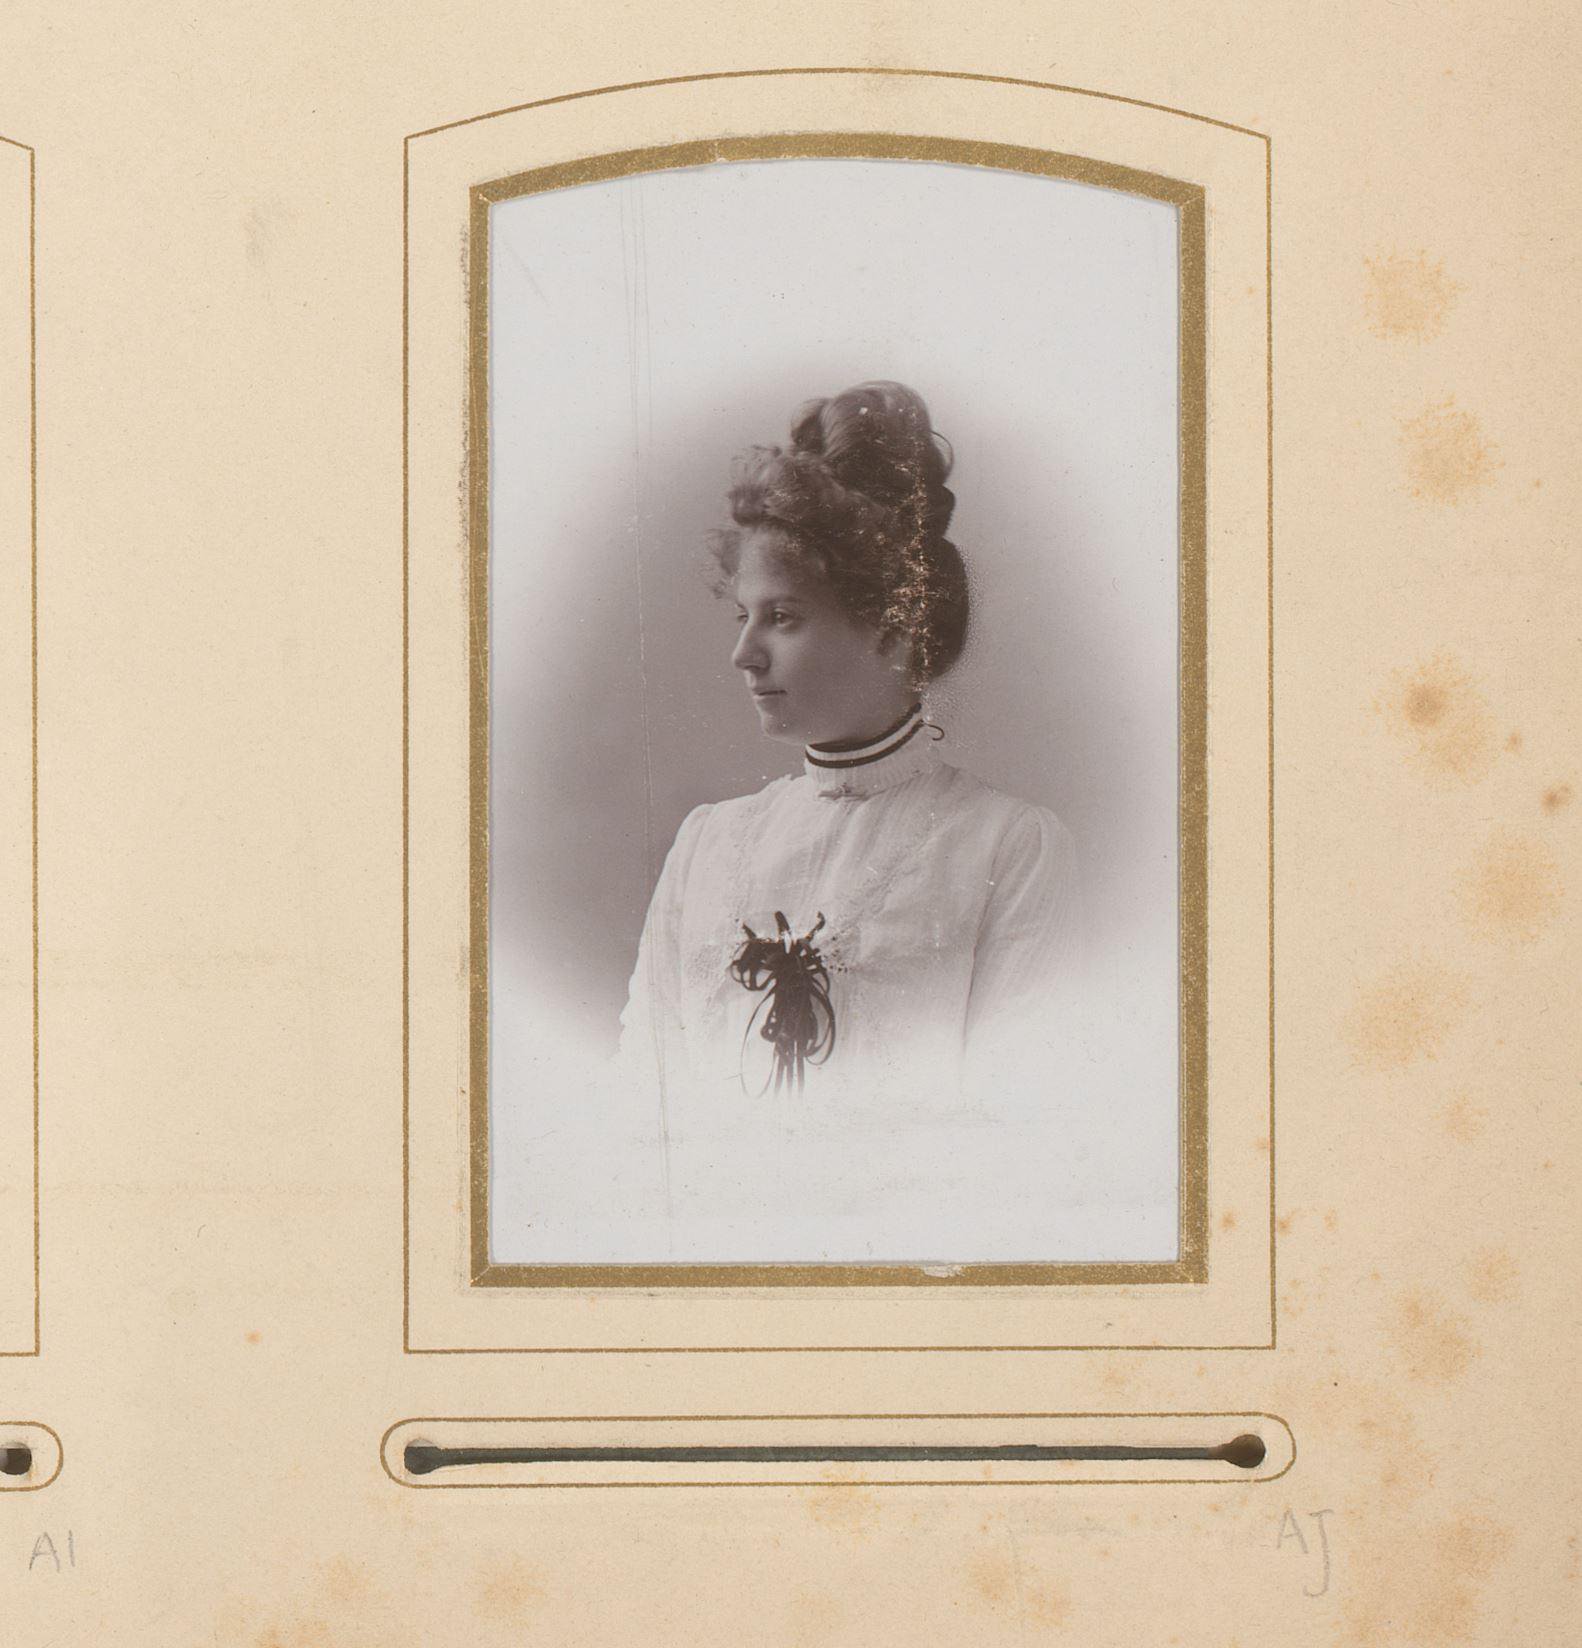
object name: album leaf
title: Portret van een jonge vrouw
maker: christian beitz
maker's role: fotograaf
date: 1880-1920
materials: cardboard, photographic support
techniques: collodion silver print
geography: arnstadt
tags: adolescent, young woman, maiden, historical persons - bb - woman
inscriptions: inscription: ‘Chr. Beitz/ Hof-Photograph/ [...]’